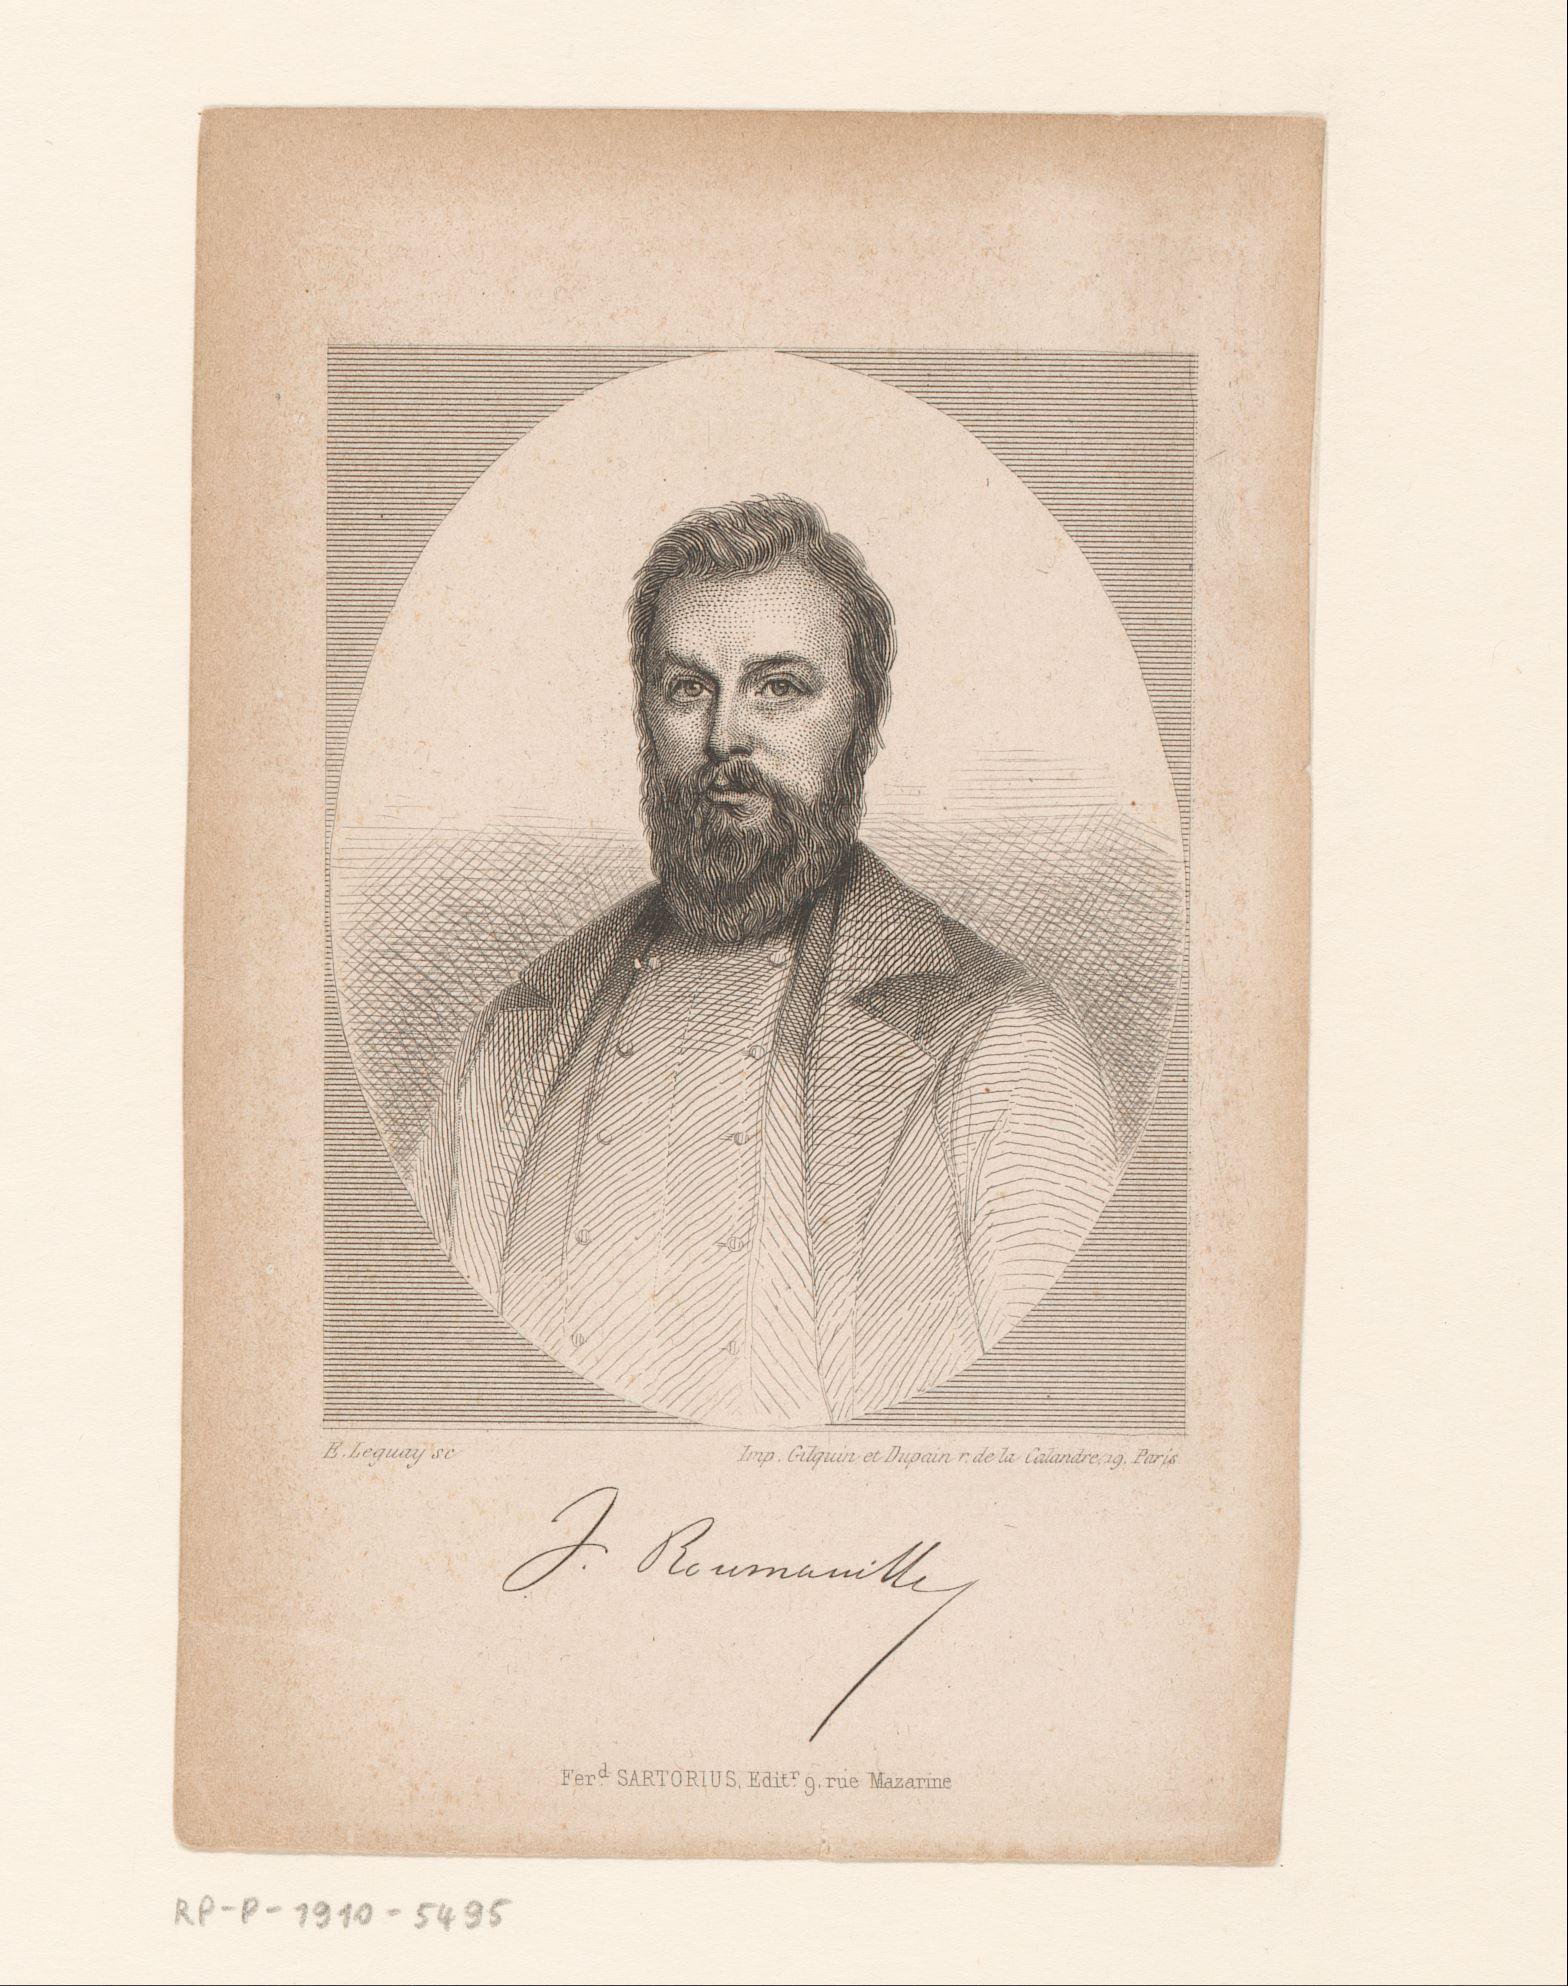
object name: print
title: Portret van Joseph Roumanille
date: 1832-1910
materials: paper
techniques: engraving, etching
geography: paris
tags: historical persons, writer, poet, author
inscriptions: collector's mark: Lugt 2228